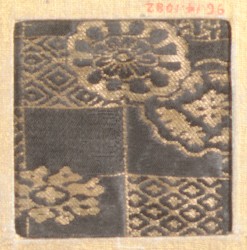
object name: piece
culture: japanese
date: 1701-1900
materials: silk